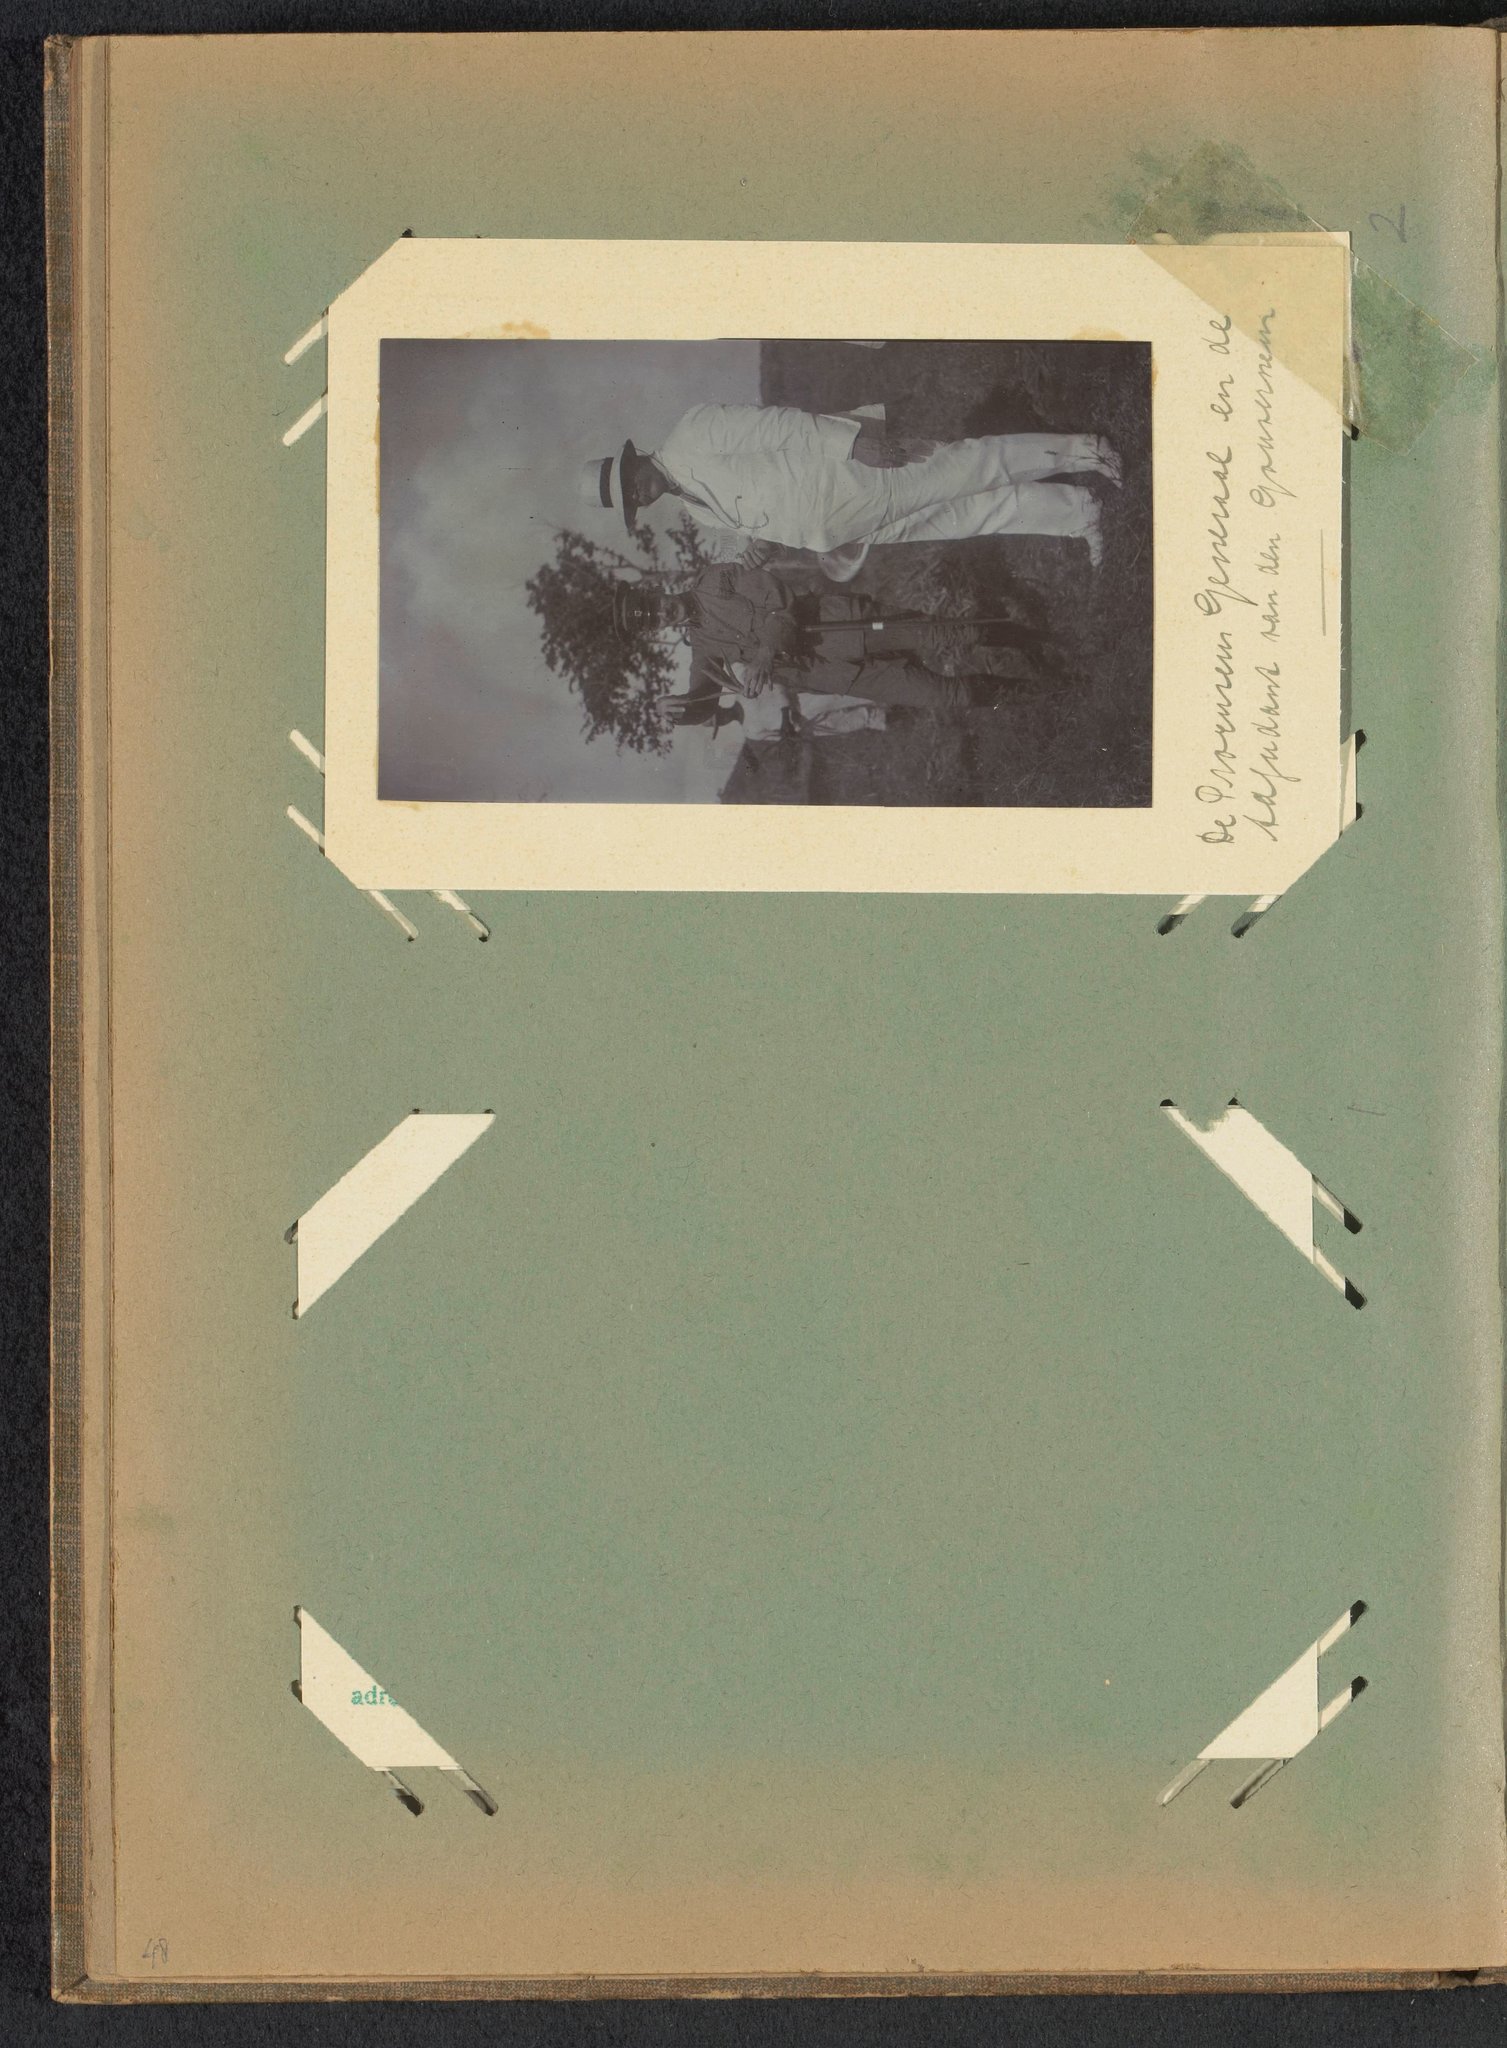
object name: photograph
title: De Procureur Generaal en de Adjudant van den Gouverneur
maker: Anonymous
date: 1912-1913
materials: paper, photographic support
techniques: gelatin silver print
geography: curacao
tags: plantation, (non-fruit) products of plants or trees: sisal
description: Groepsfoto bij het bezoek van de gouverneur Nuijens aan de sisalplantage Mount Pleasant op Curaçao. Onderdeel van het fotoalbum uit ca. 1912-1913 met 92 foto's van de plantages Peperpot en Dordrecht in Suriname en Mount Pleasant op Curaçao.